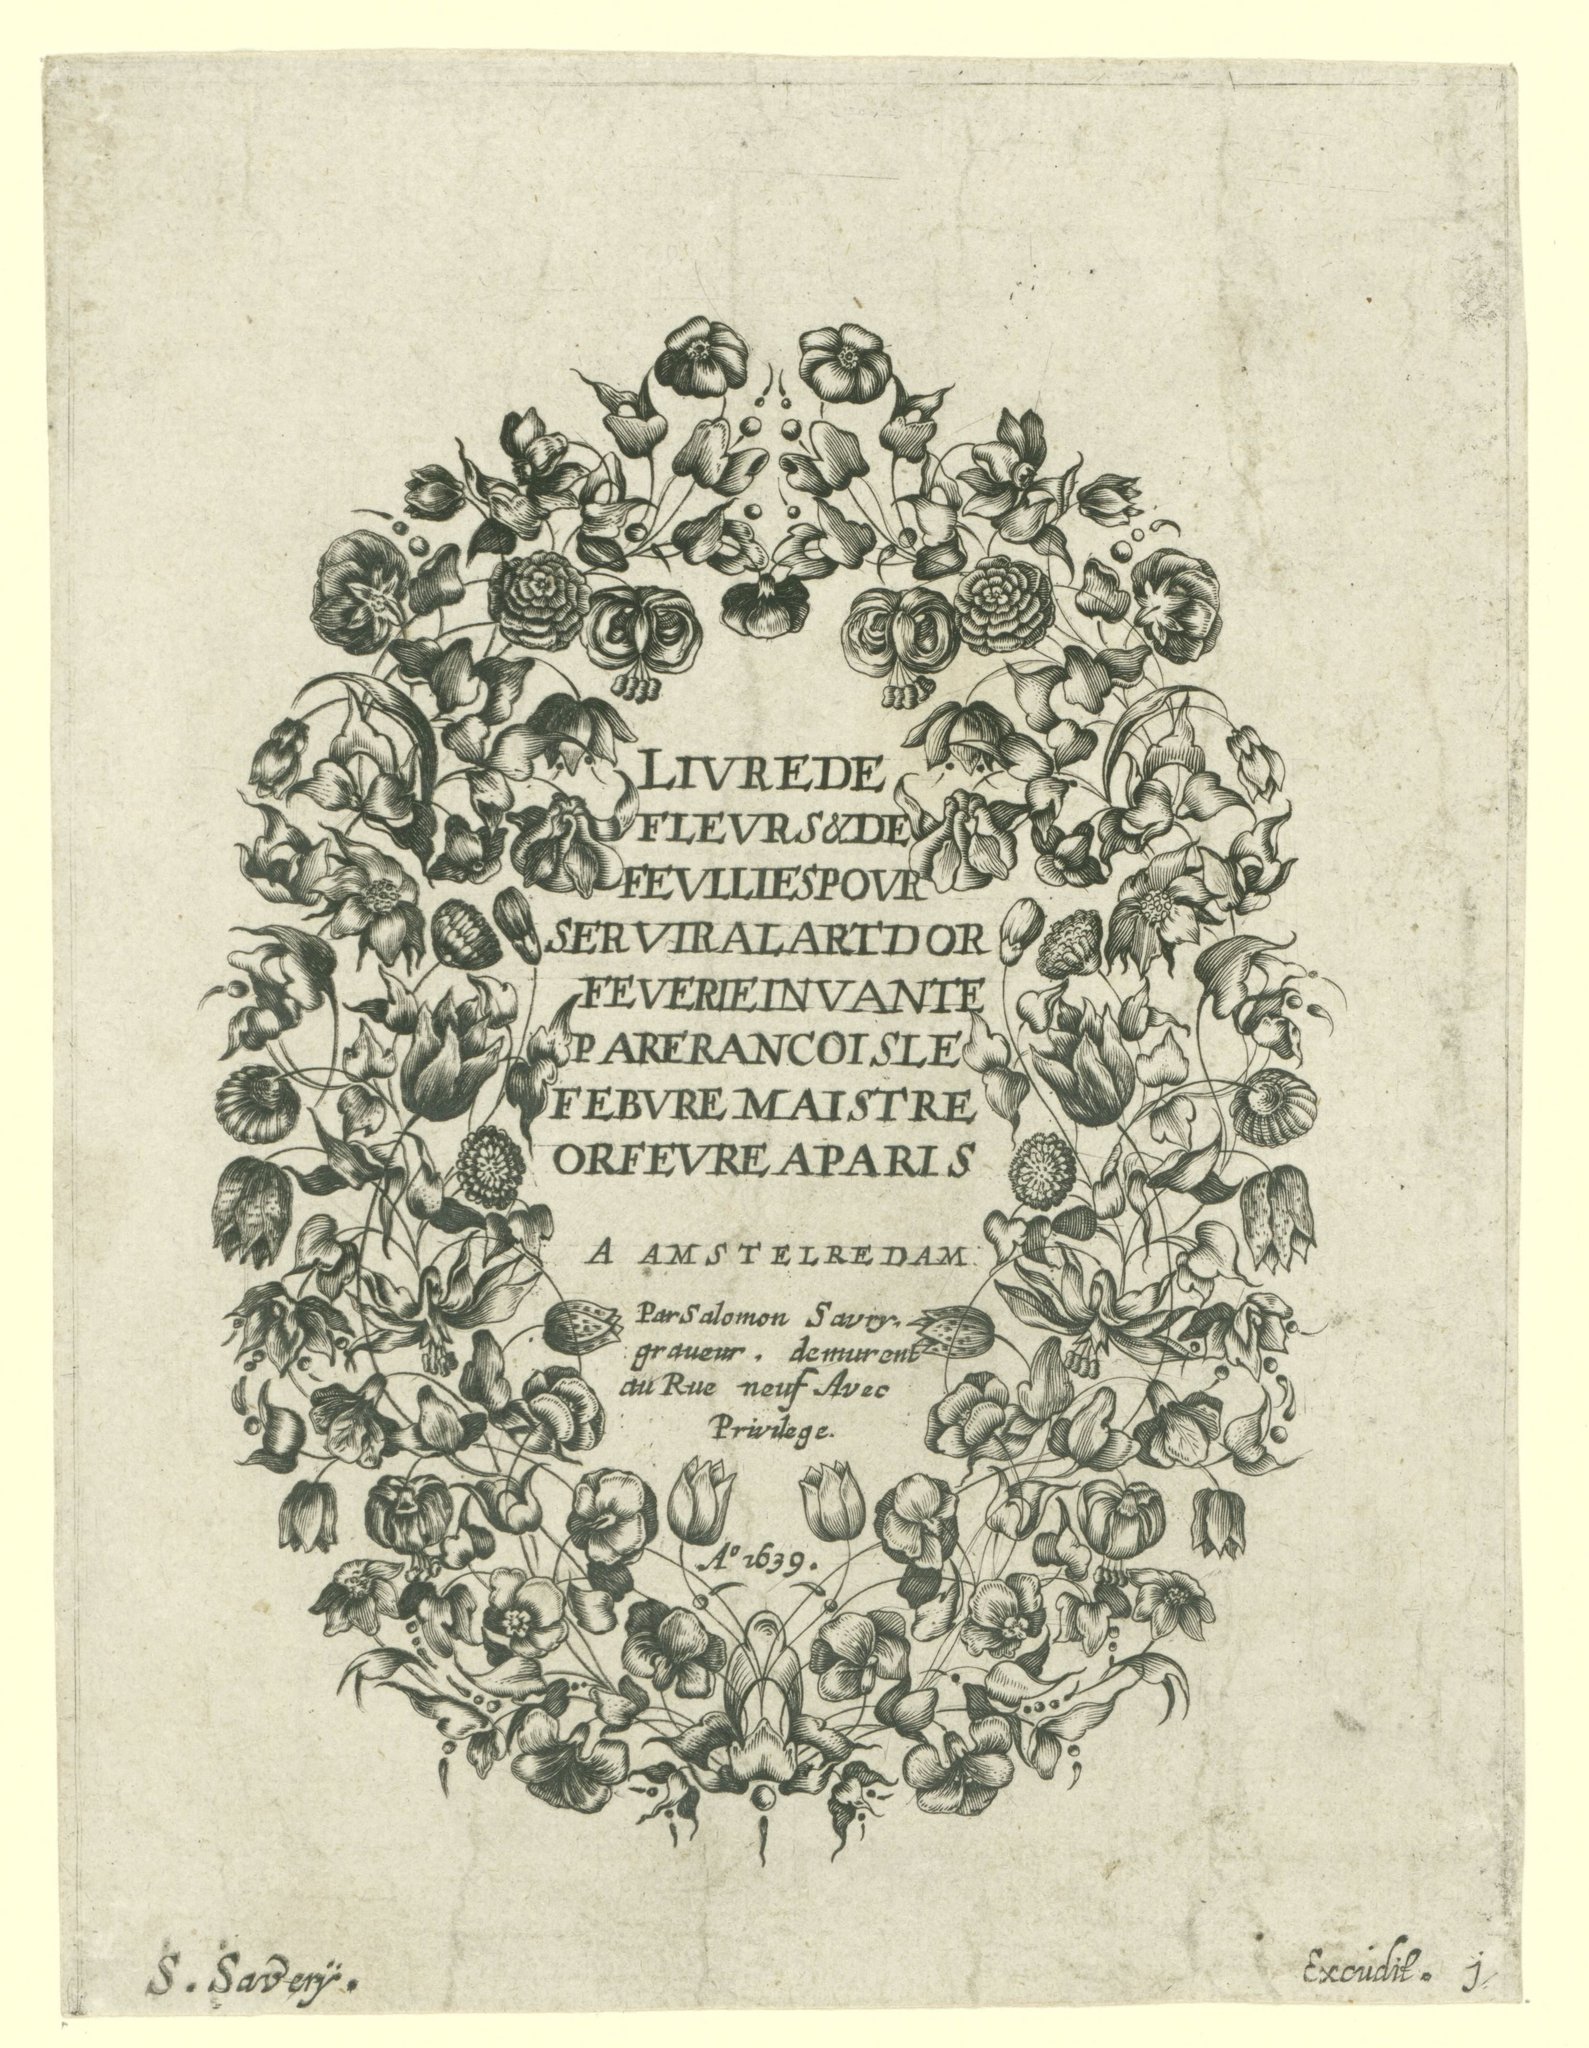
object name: print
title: Livre de Fleurs & de Feuilles pour servir a l'art d'orfevrerie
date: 1639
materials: paper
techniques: engraving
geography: amsterdam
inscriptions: title: ‘Livre de Fleurs & de Feuillies pour servir alart dor/feverie invante / parFrancoisle / febure maistre / orfeure a Paris / a Amstelredam.’, date: ‘1639’, address: ‘S. Savery Excudit’, number, address: ‘Par Salomon Sav[e]ry graveur demurent au Rue neuf Avec Privilege’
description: Titel in staand ovaal opgebouwd uit bloemen.